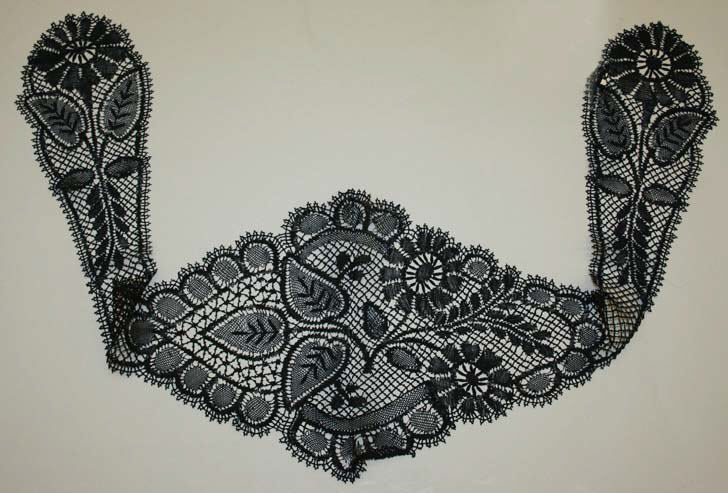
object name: barbe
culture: american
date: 1850-1859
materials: cotton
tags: flowers